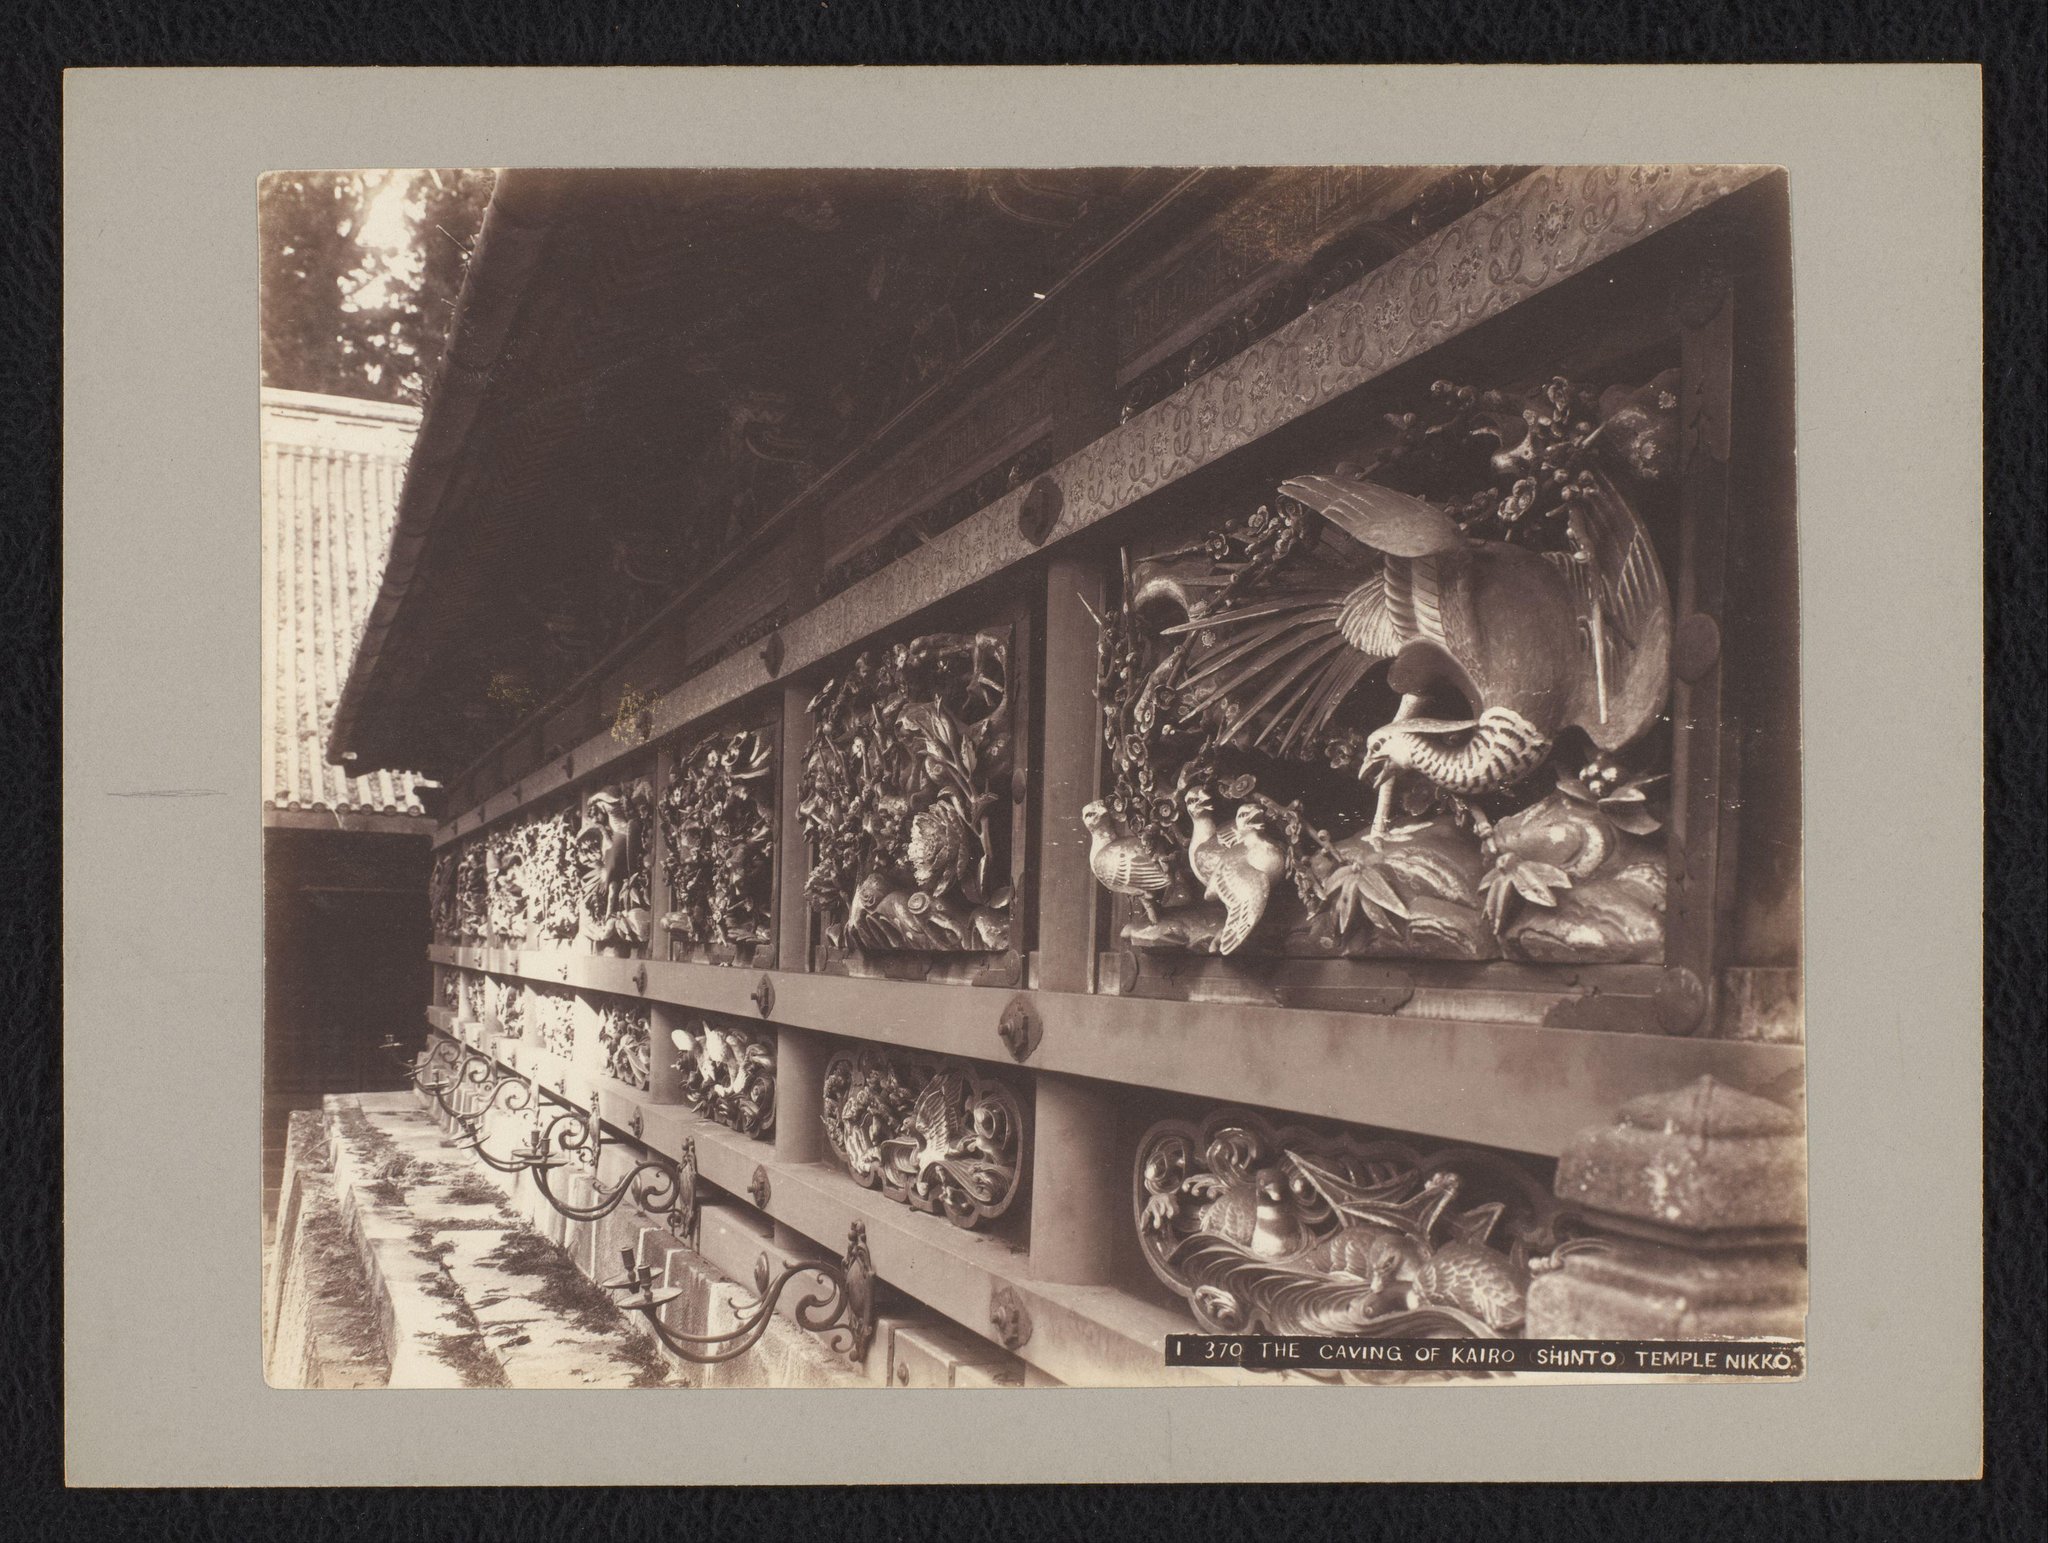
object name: photograph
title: I 370 The caving of Kairo Shinto Temple Nikko.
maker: Anonymous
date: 1895-1915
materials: cardboard, photographic support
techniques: salted paper print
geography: nikko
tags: nikko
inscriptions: number: ‘34.’